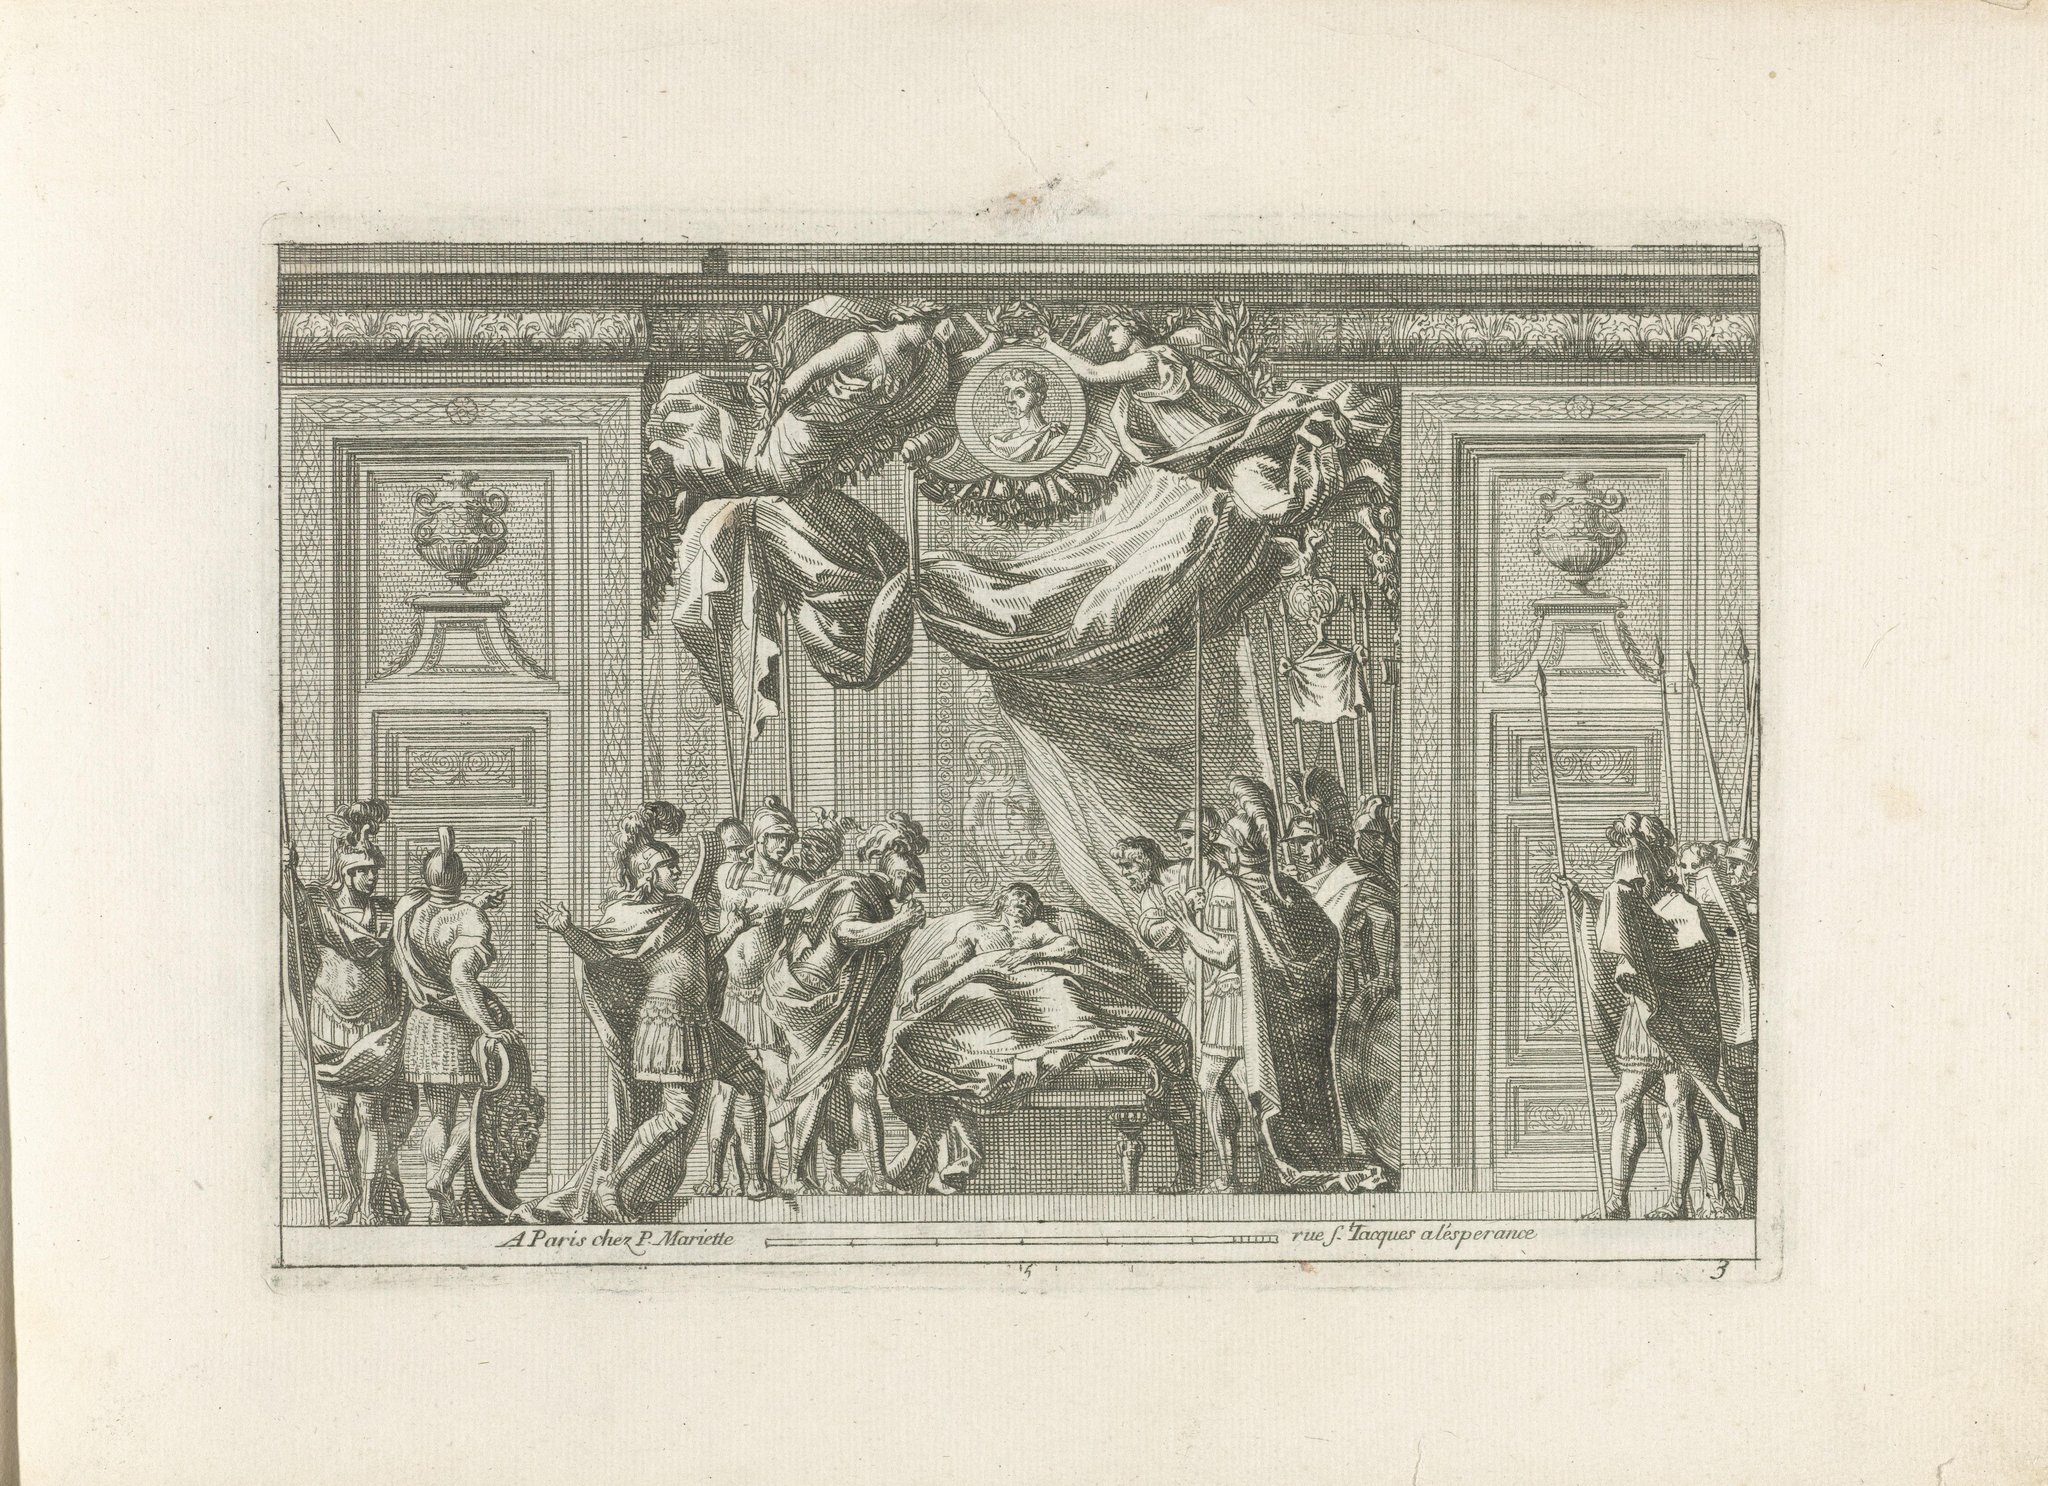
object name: ornament print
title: Alcoves a la Romaine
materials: paper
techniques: etching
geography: france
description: Alkoof met Germanicus liggend op een bed met daarboven draperieën en engelen met lauwerkrans. Rondom staan treurende soldaten. Rechtsonder 3 genummerd.